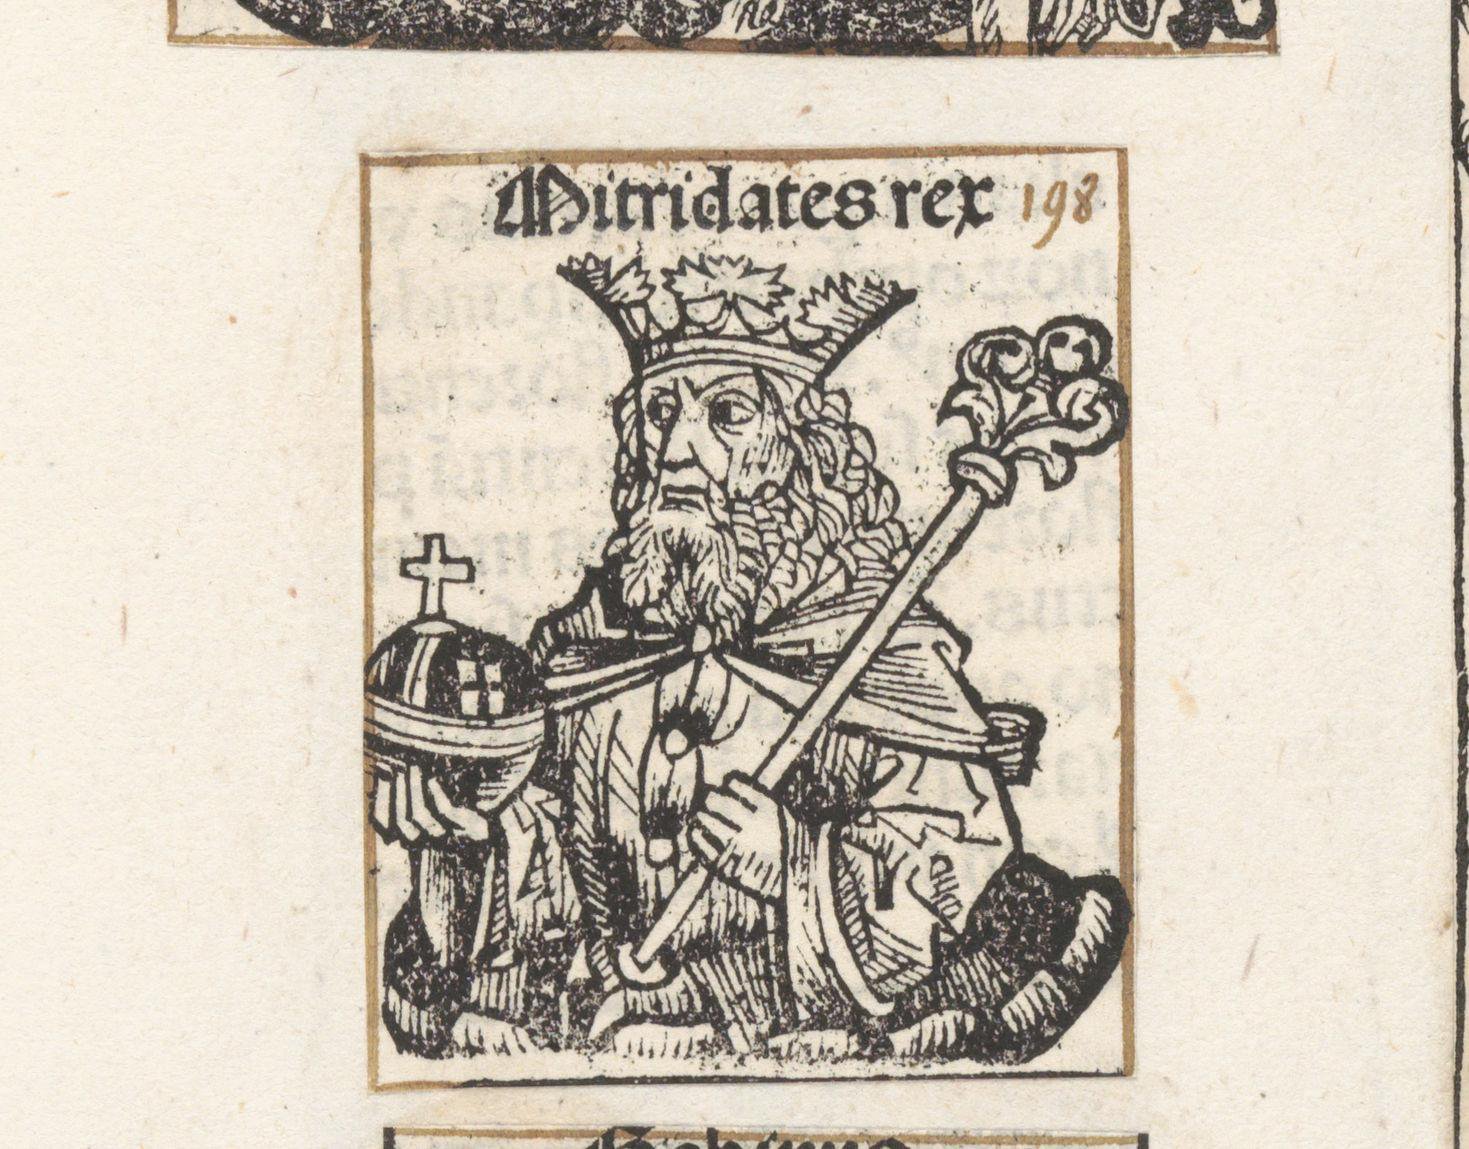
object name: album leaf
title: Liber Chronicarum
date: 1493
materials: paper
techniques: letterpress printing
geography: nuremberg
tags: male persons from classical history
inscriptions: inscription: ‘198’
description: De houtsnede wordt gebruikt als boekillustratie in de Liber Chronicarum (of Neurenbergkroniek) van Hartmann Schedel, verschenen in het Latijn en Duits in 1493. Zie de Latijnse uitgave, folio 87v.